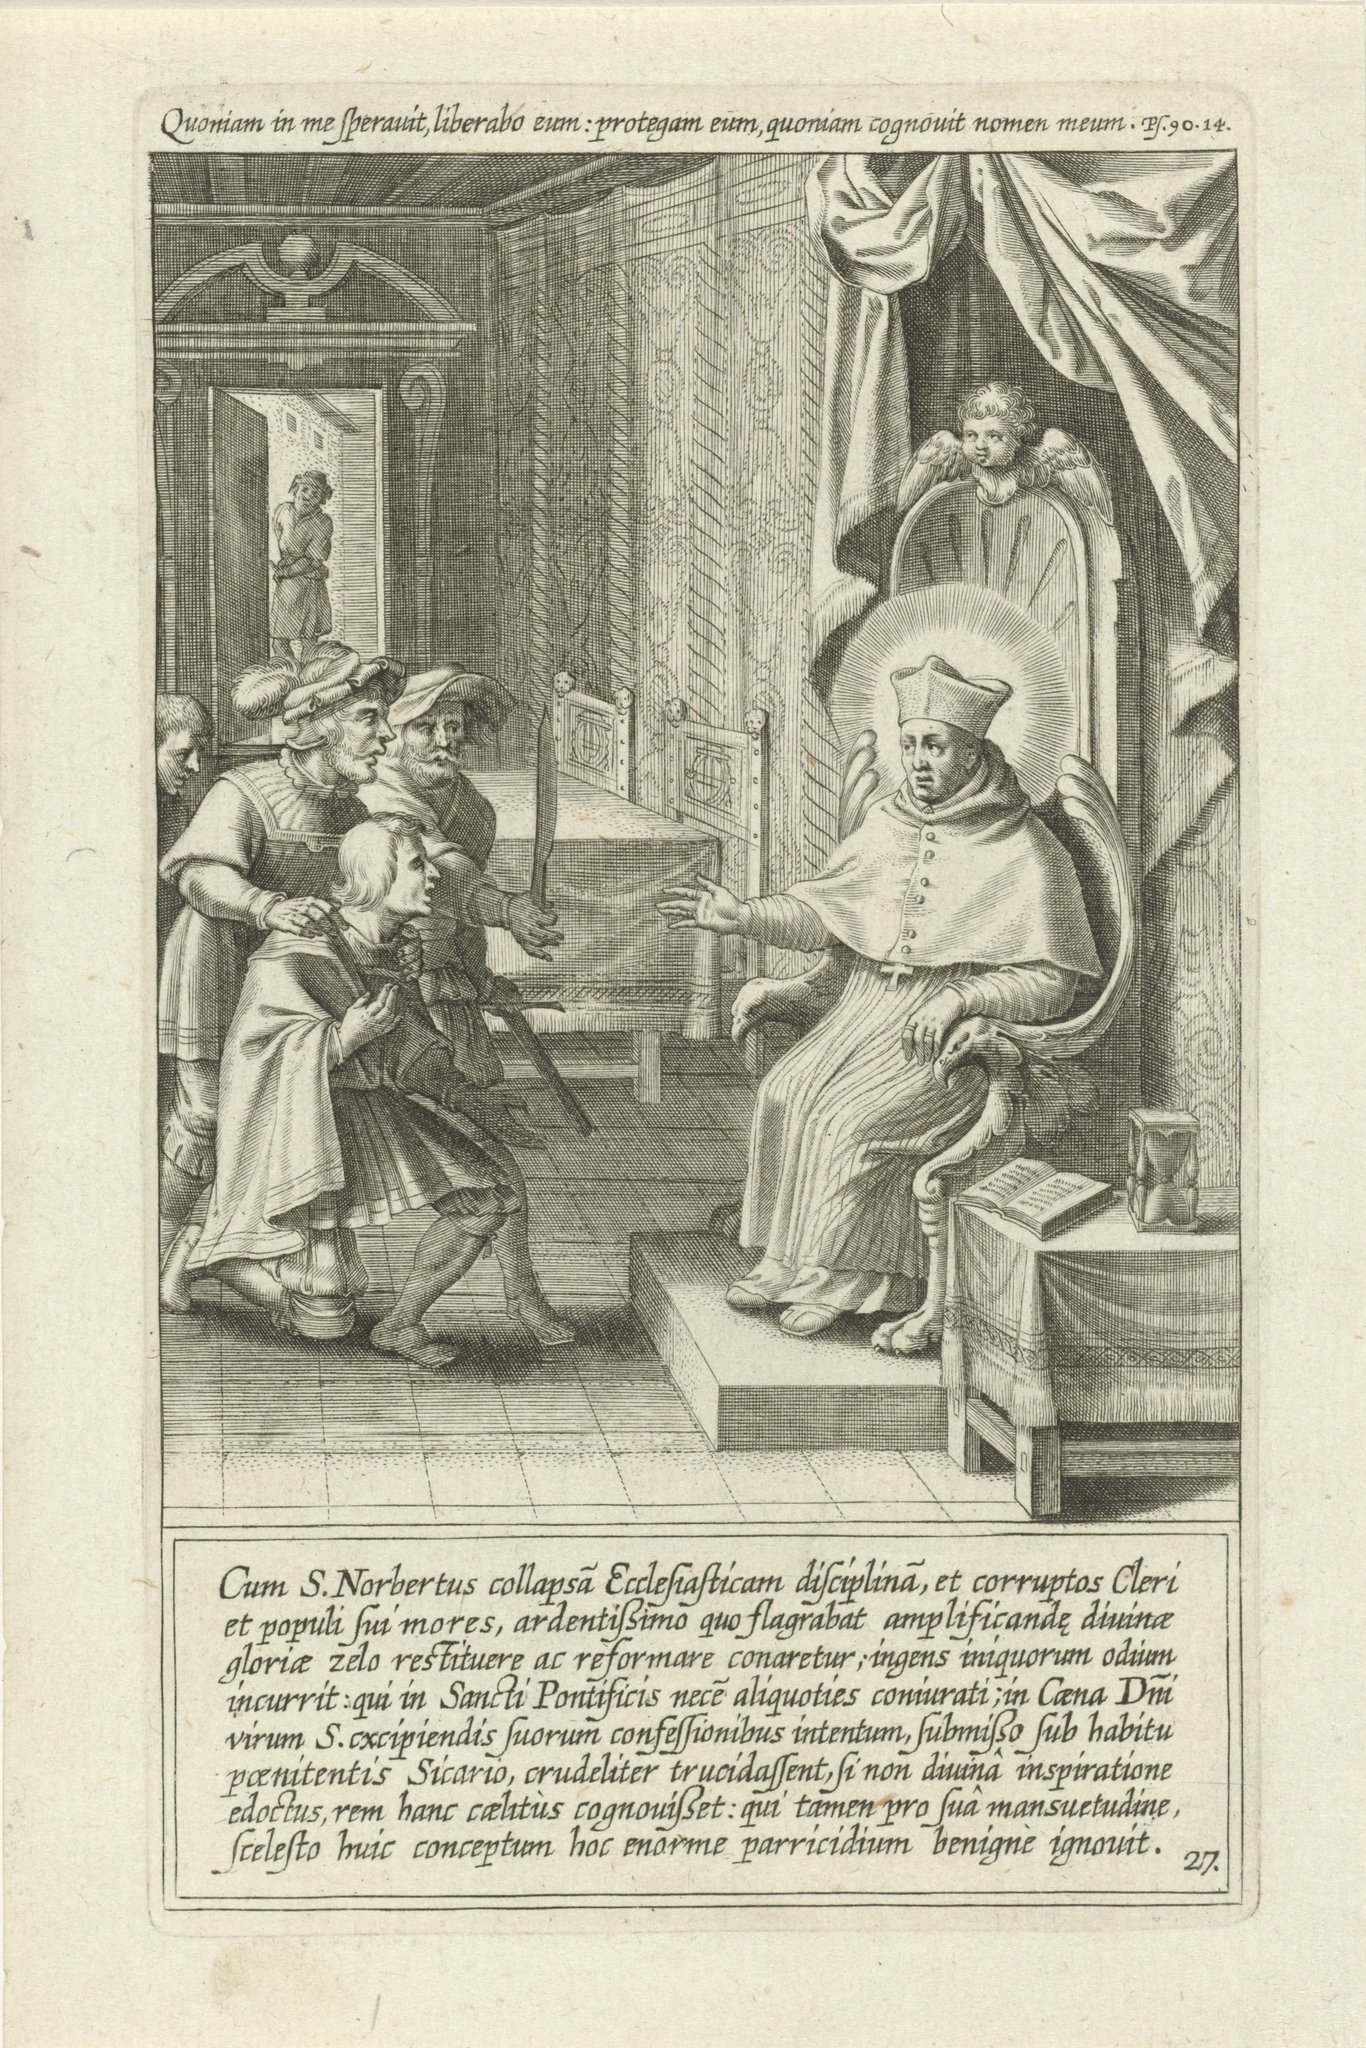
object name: book illustration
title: Moordaanslag op de heilige Norbertus wordt verijdeld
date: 1622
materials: paper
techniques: engraving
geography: antwerp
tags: martyrdom, suffering, misfortune, death of st. norbert, hacking and thrusting weapons: dagger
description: Een jongeling wordt door wachters voor de heilige Norbertus gebracht. De jongen had een dolk verborgen onder zijn kledij. De prent heeft twee Latijnse opschriften: een boven en een onder de voorstelling.